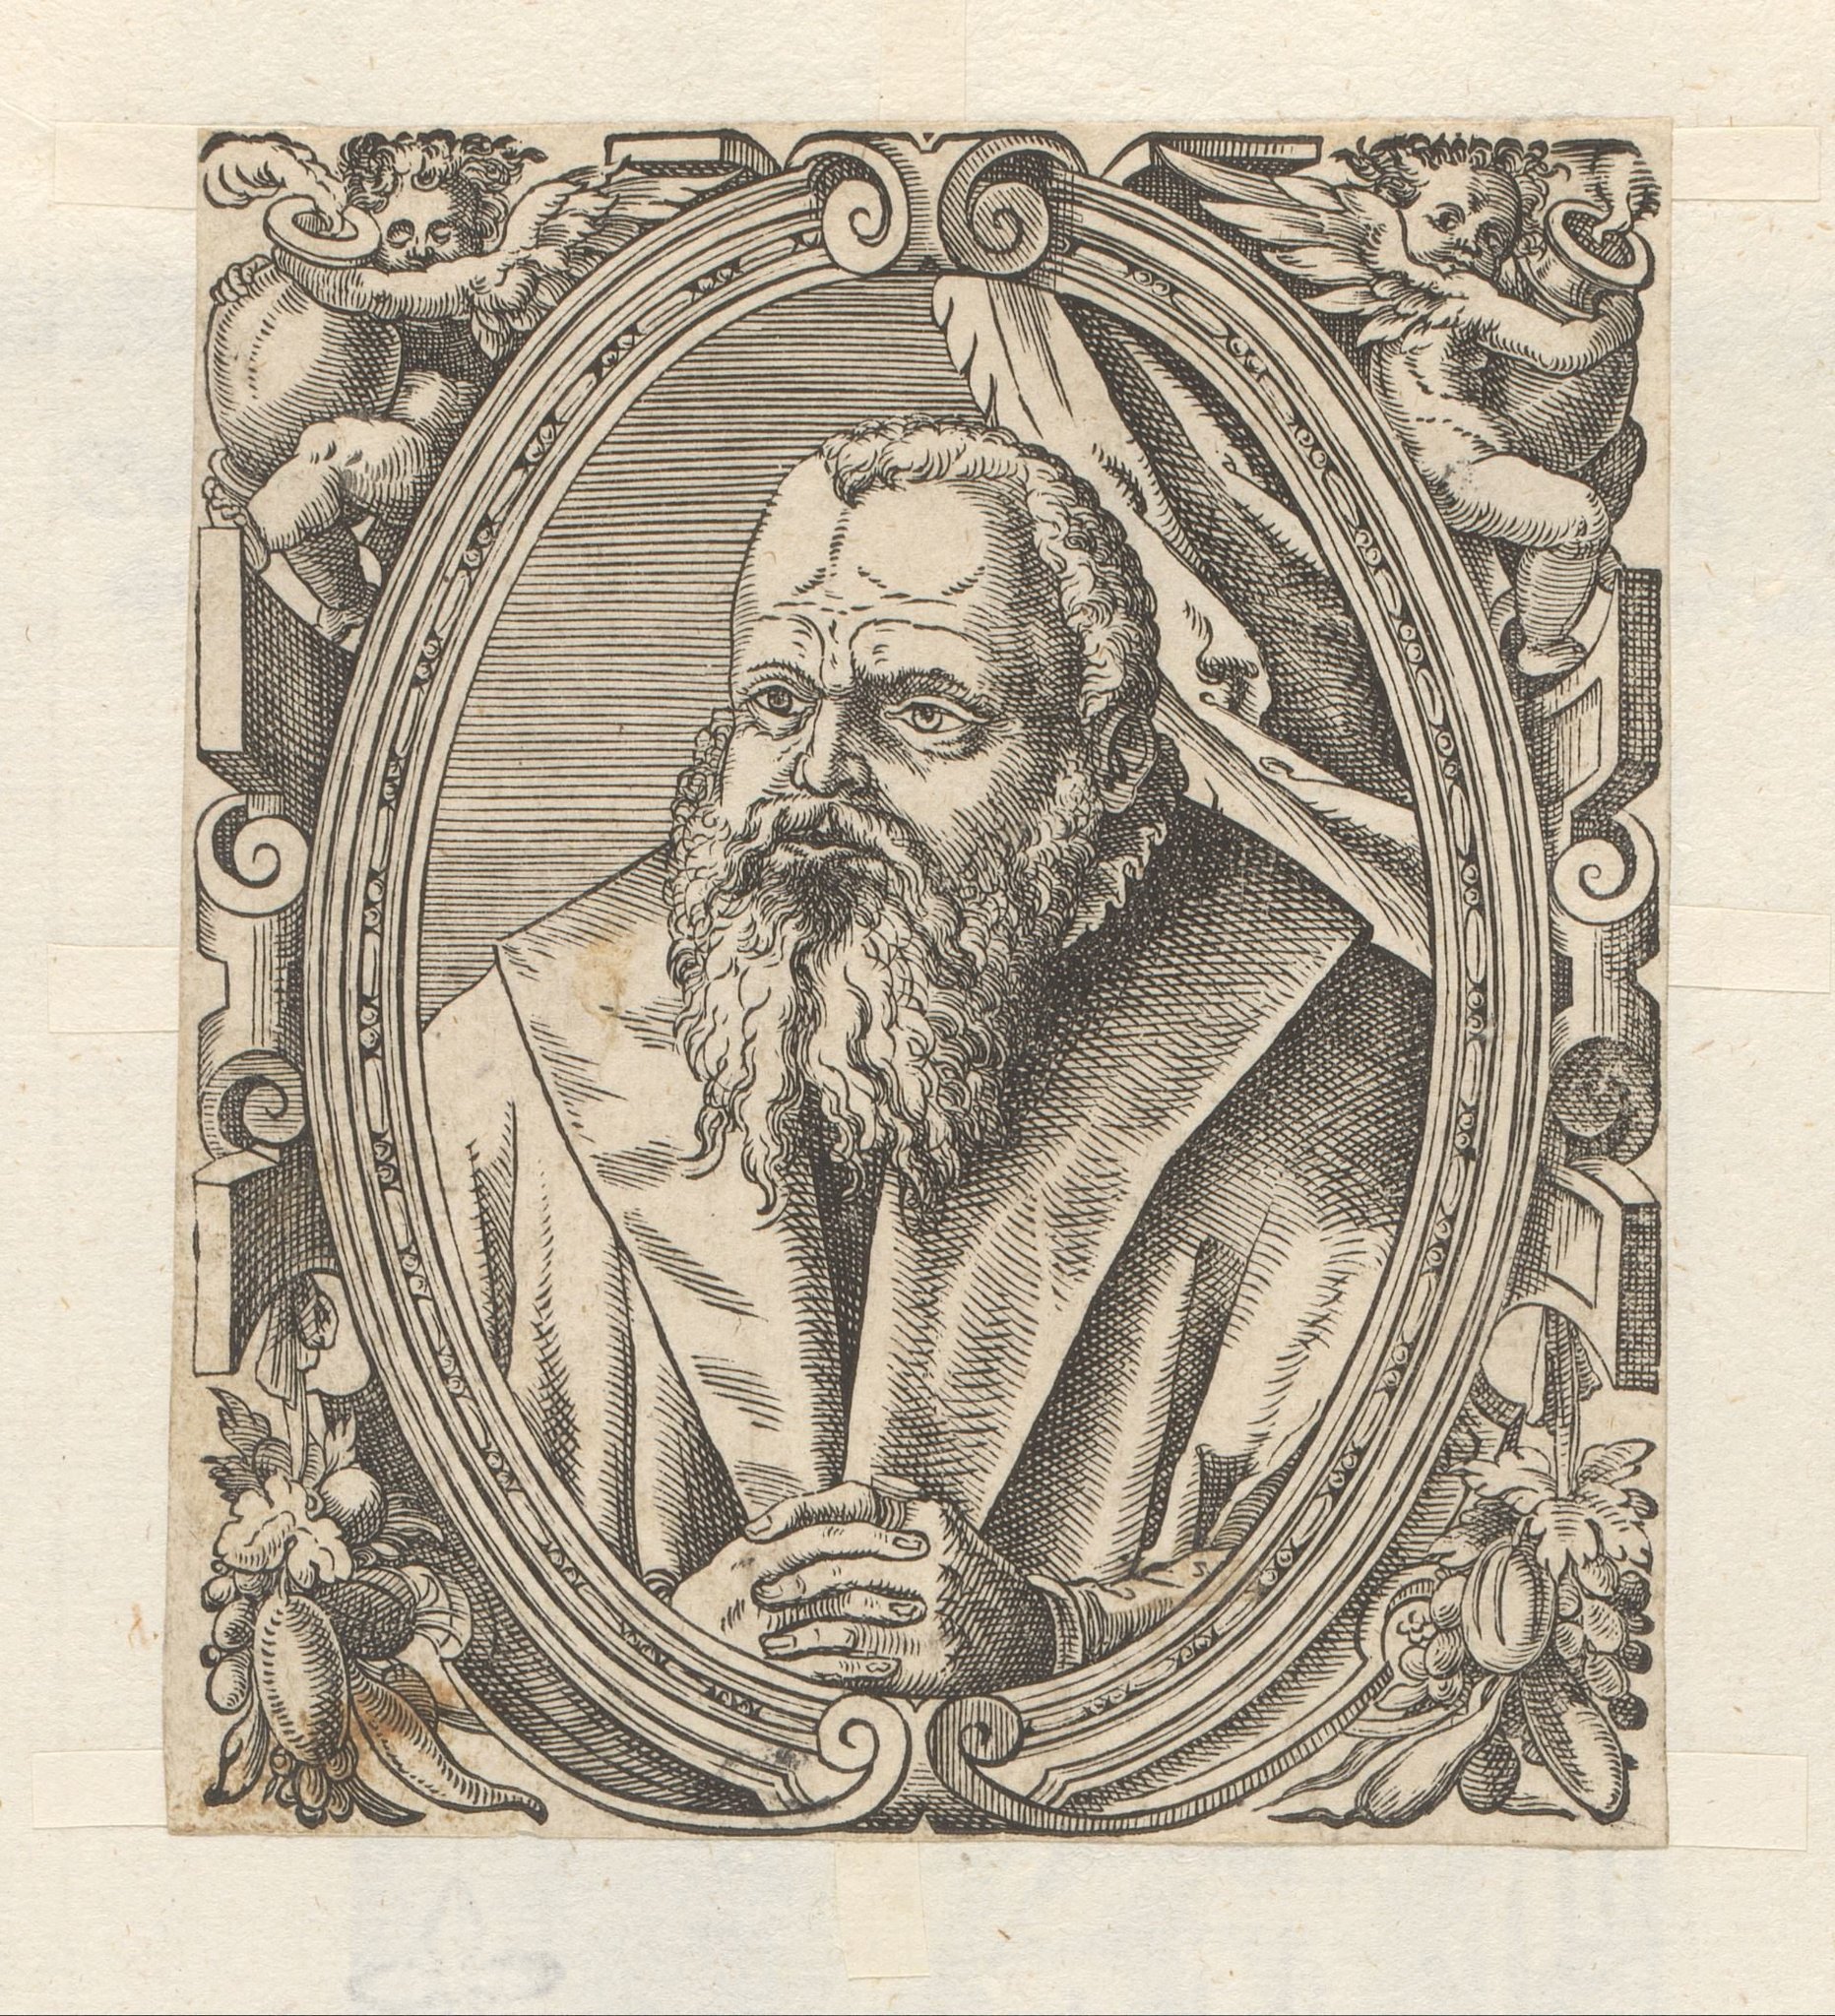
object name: album leaf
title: Portret van een onbekende man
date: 1549-1584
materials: paper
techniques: woodcut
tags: historical persons